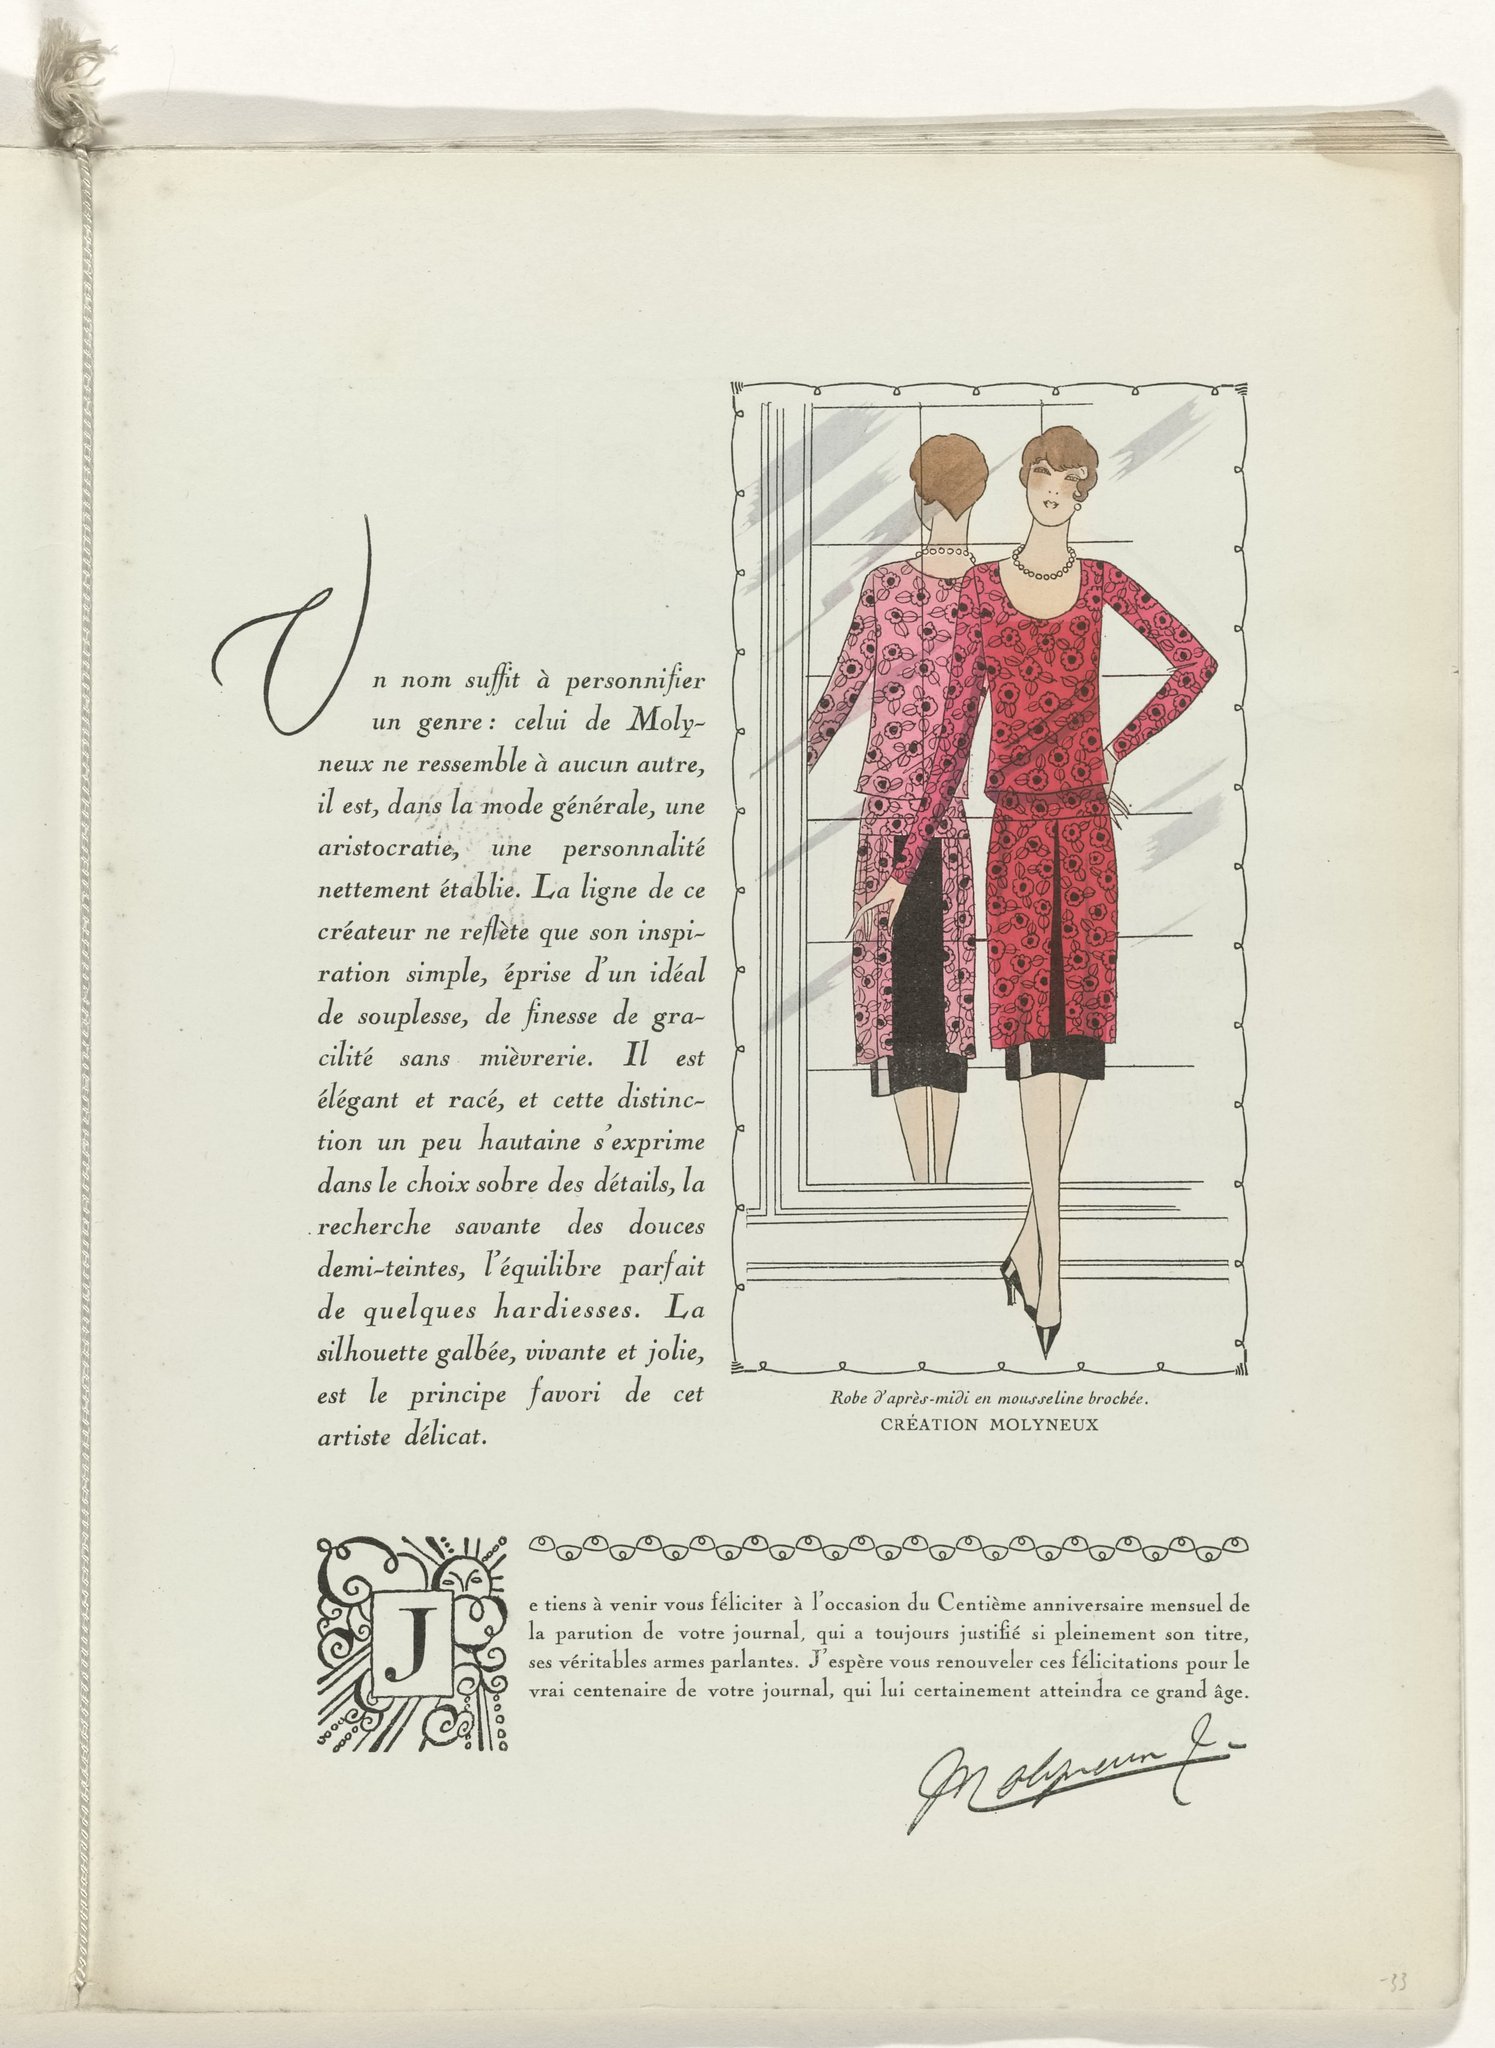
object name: fashion print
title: Art - Goût - Beauté, Feuillets de l' élégance féminine, Noël 1928, No. 100, 9e Année, p. 33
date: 1928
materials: paper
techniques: hand coloring, lithograph, pochoir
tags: dress, gown: day dress (+ women's clothes), fashion plates, necklace (+ women's clothes)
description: Tekst met een afbeelding van een vrouw, staande met de rug naar een spiegel, gekleed in een middagjapon van gebrocheerde mousseline met bloemmotief, van Molyneux. Pagina uit het modetijdschrift Art-Goût-Beauté (1920-1933).